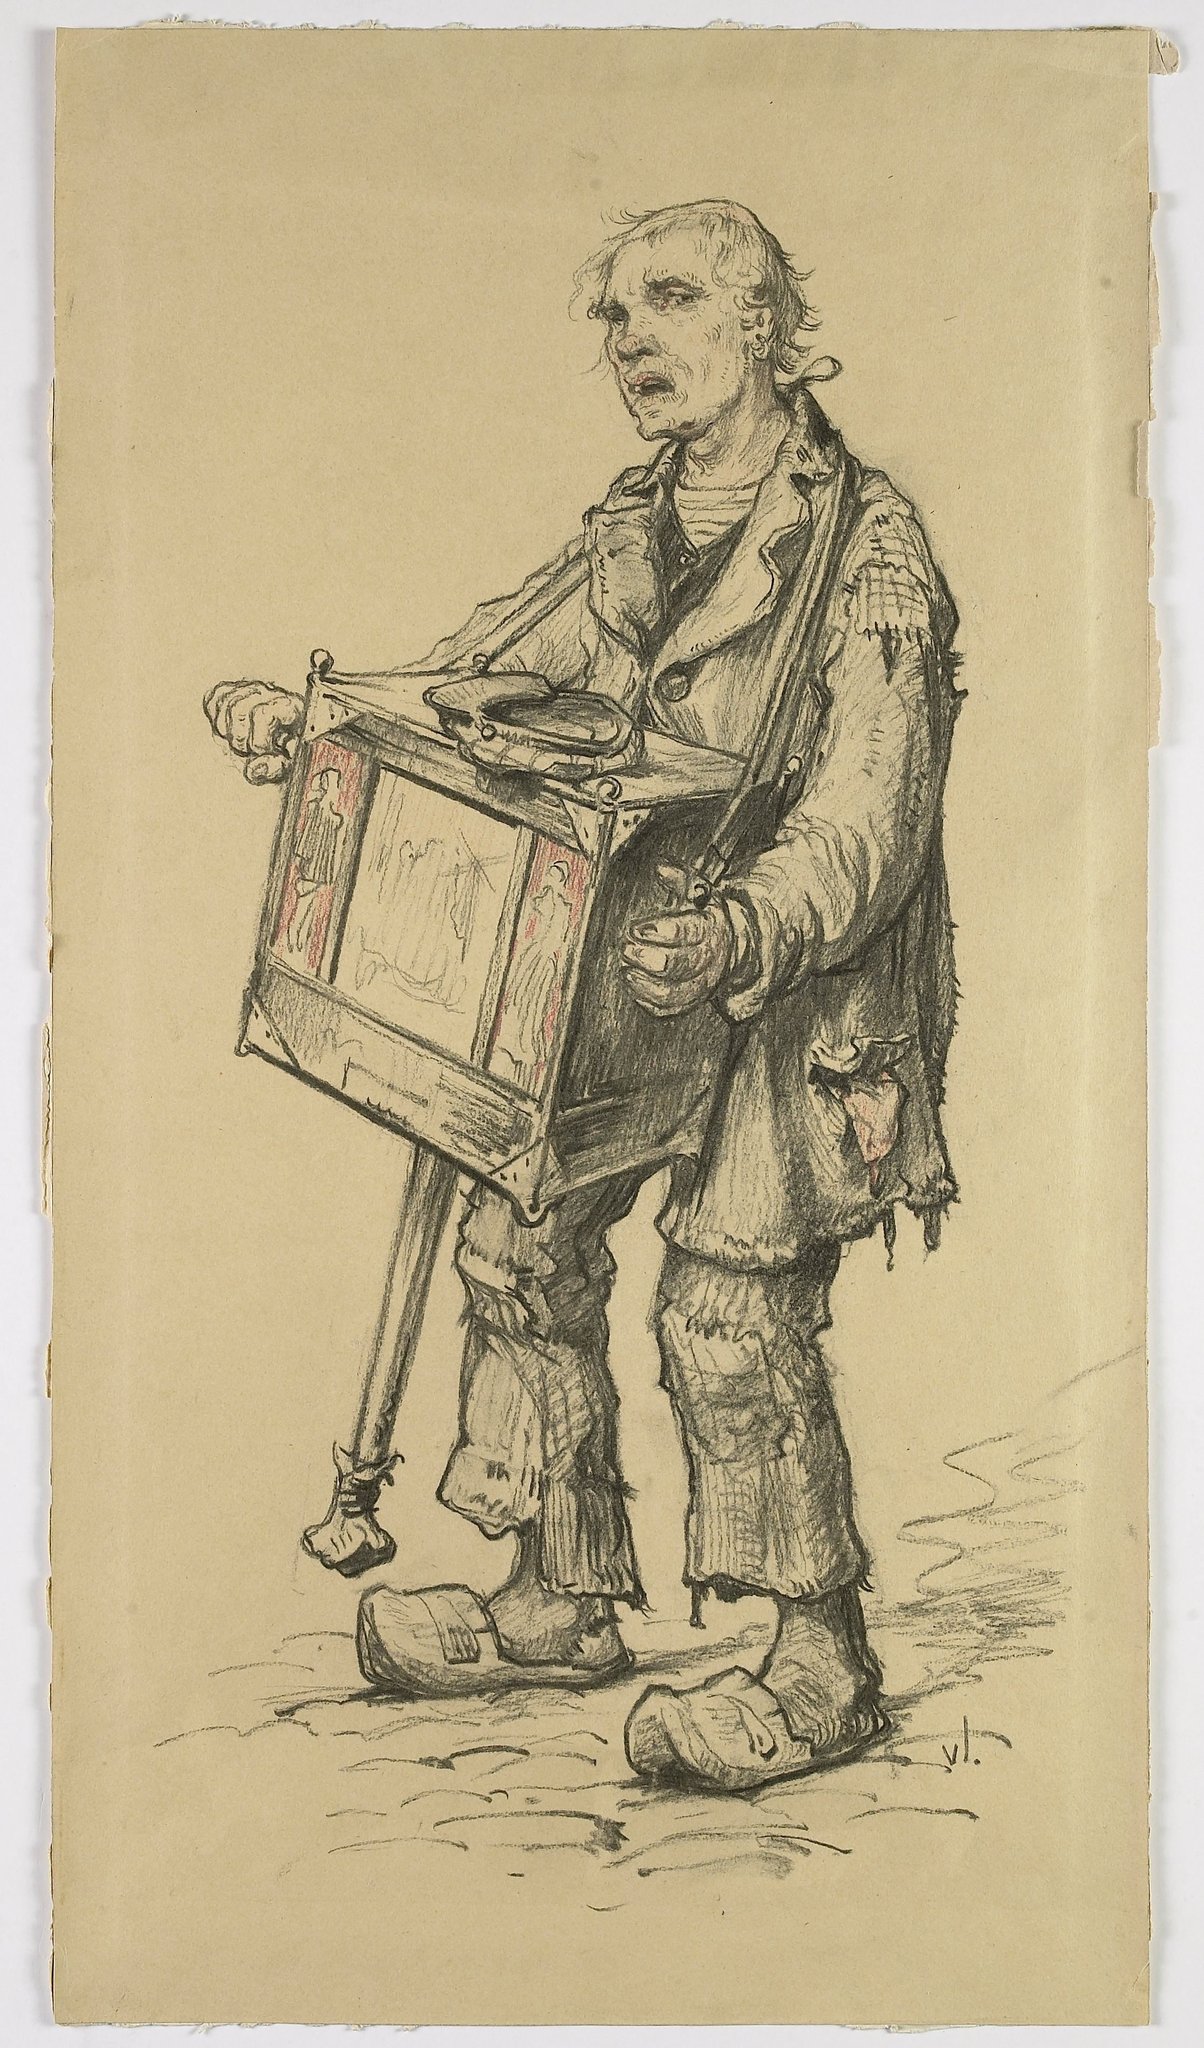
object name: drawing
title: Orgeldraaier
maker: jacobus laurentius van ishoven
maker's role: draughtsman, print maker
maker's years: 1870-1931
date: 1880-1931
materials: chalk, charcoal, paper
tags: clothed in rags, barrel-organ player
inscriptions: inscription: ‘J.L. v.Ishoven’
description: De man draagt klompen en kleren met gaten en verstelde stukken stof.